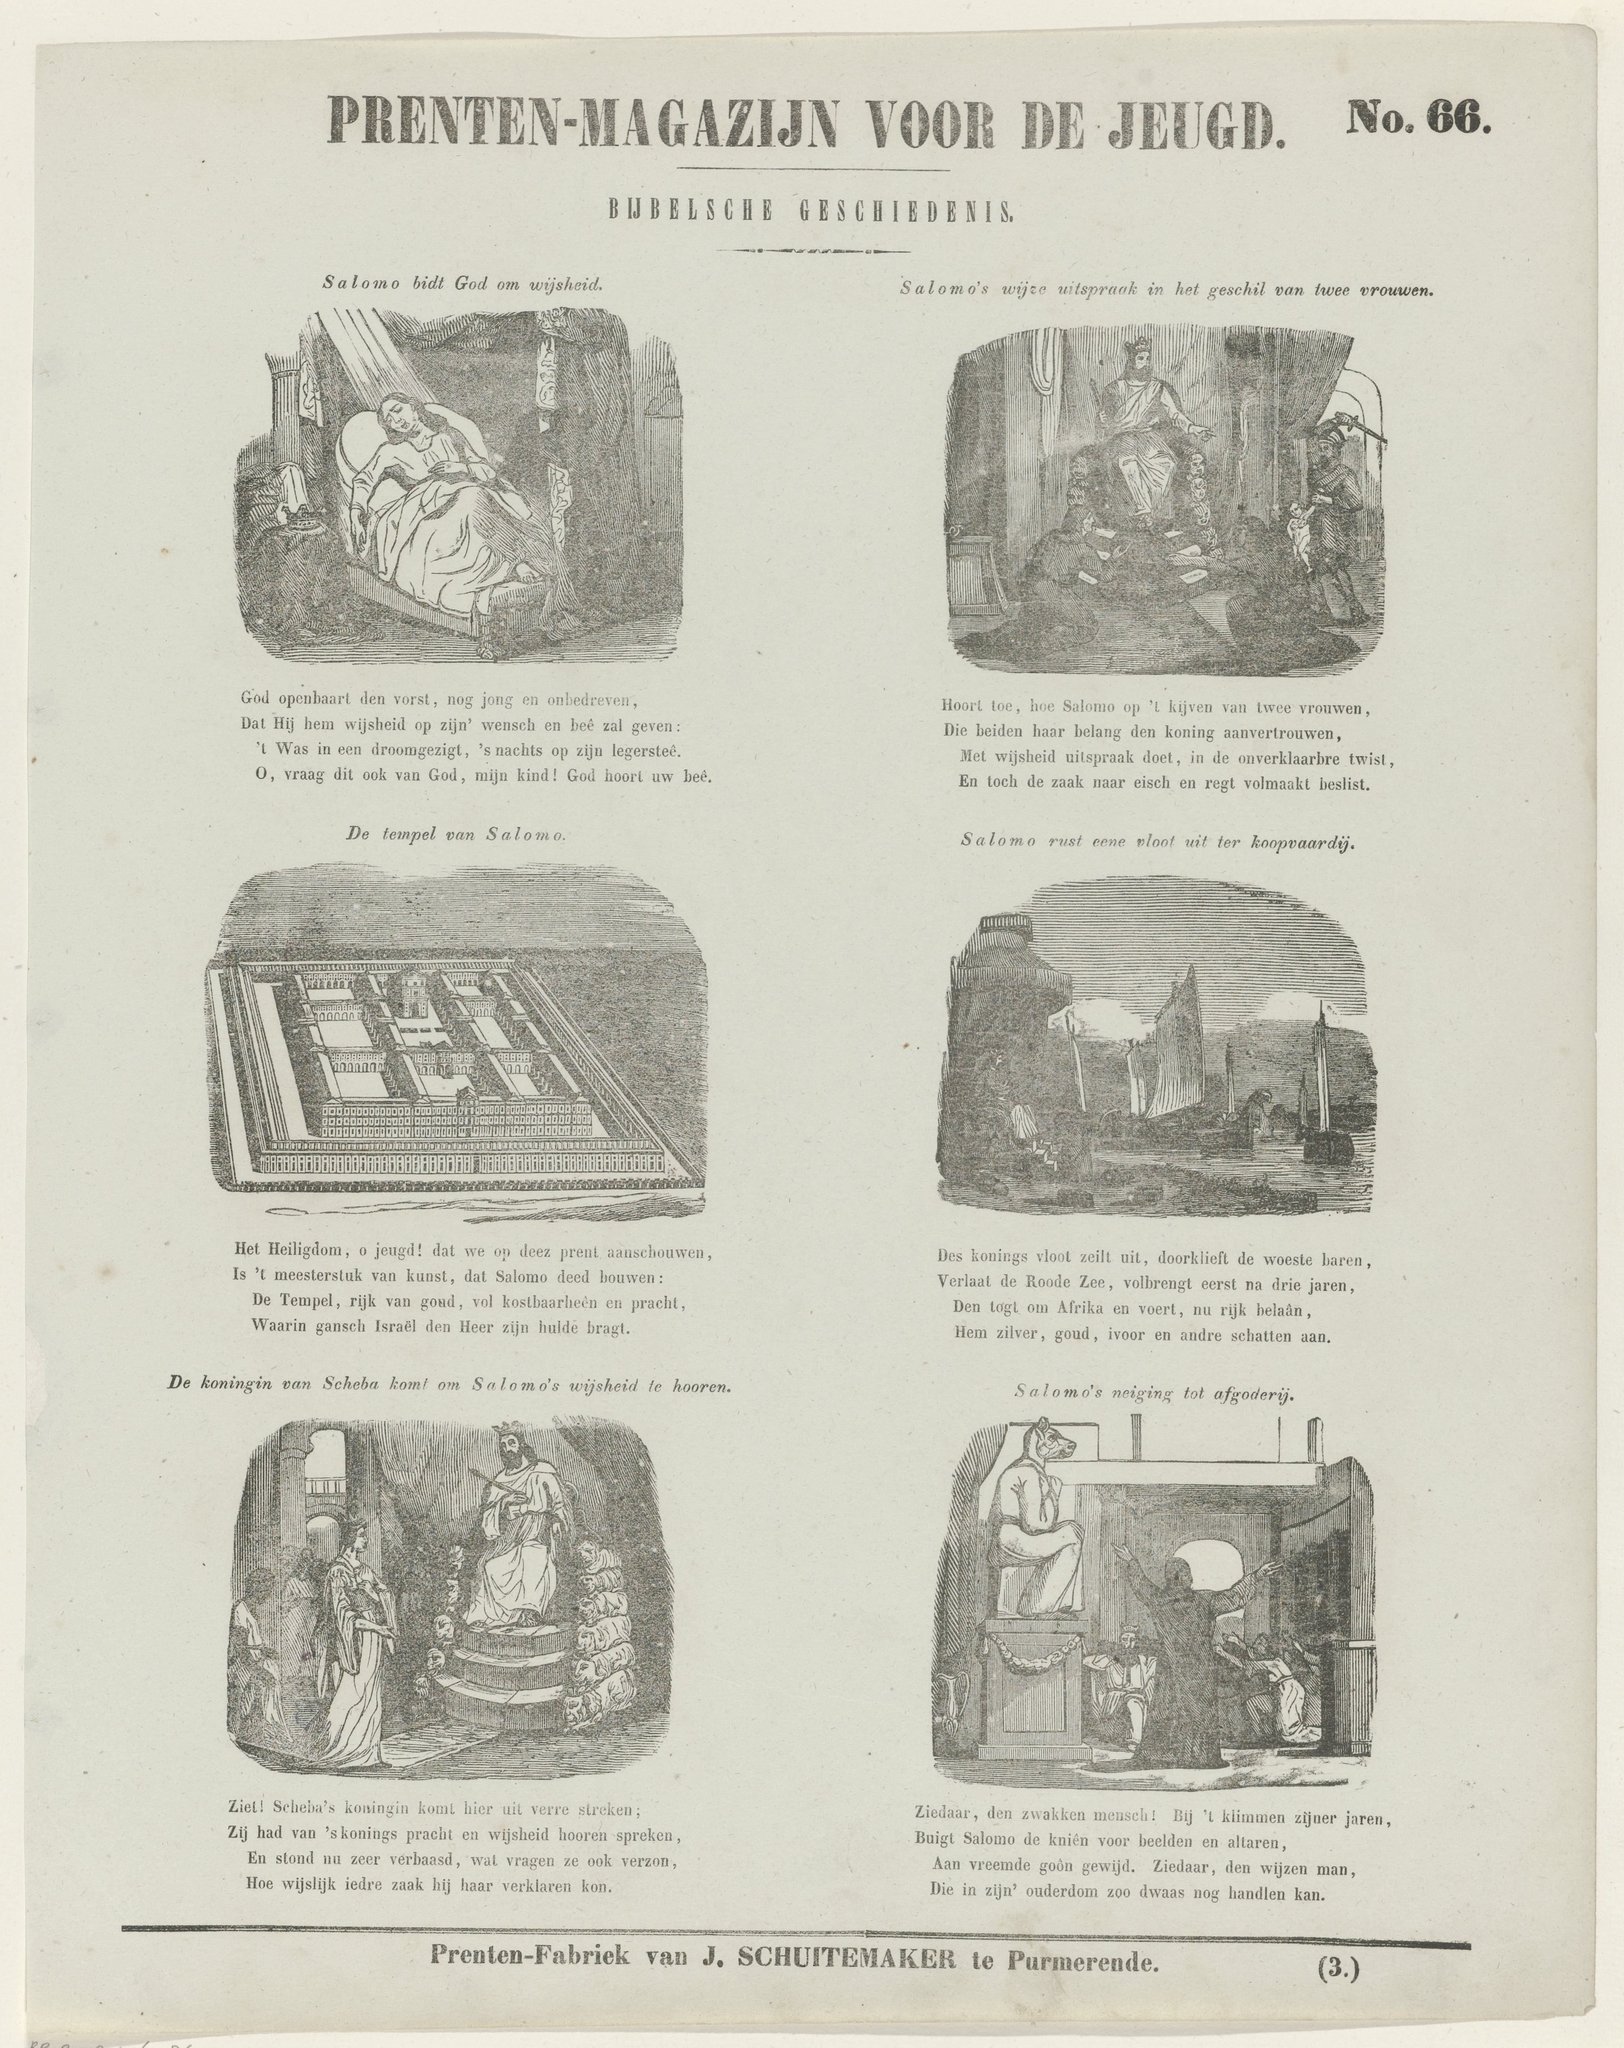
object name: popular print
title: Bijbelsche geschiedenis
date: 1850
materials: paper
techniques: letterpress printing, engraving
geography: purmerend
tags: temple of solomon (1 kings 5-9; 2 chronicles 2-7), story of solomon, old testament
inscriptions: collector's mark: Lugt 2760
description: Na voltooiing van de acht jaargangen van de reeks 'Prenten-magazijn voor de jeugd' in 1850 heeft Jan Schuitemaker al deze prenten heruitgegeven en omgenummerd als nr. 1 t/m 192. De oorspronkelijke jaargang wordt telkens nog vermeld rechtsonder op de prent. Binnen de jaargangen zijn prenten van hetzelfde thema in clusters van vier achter elkaar gezet.